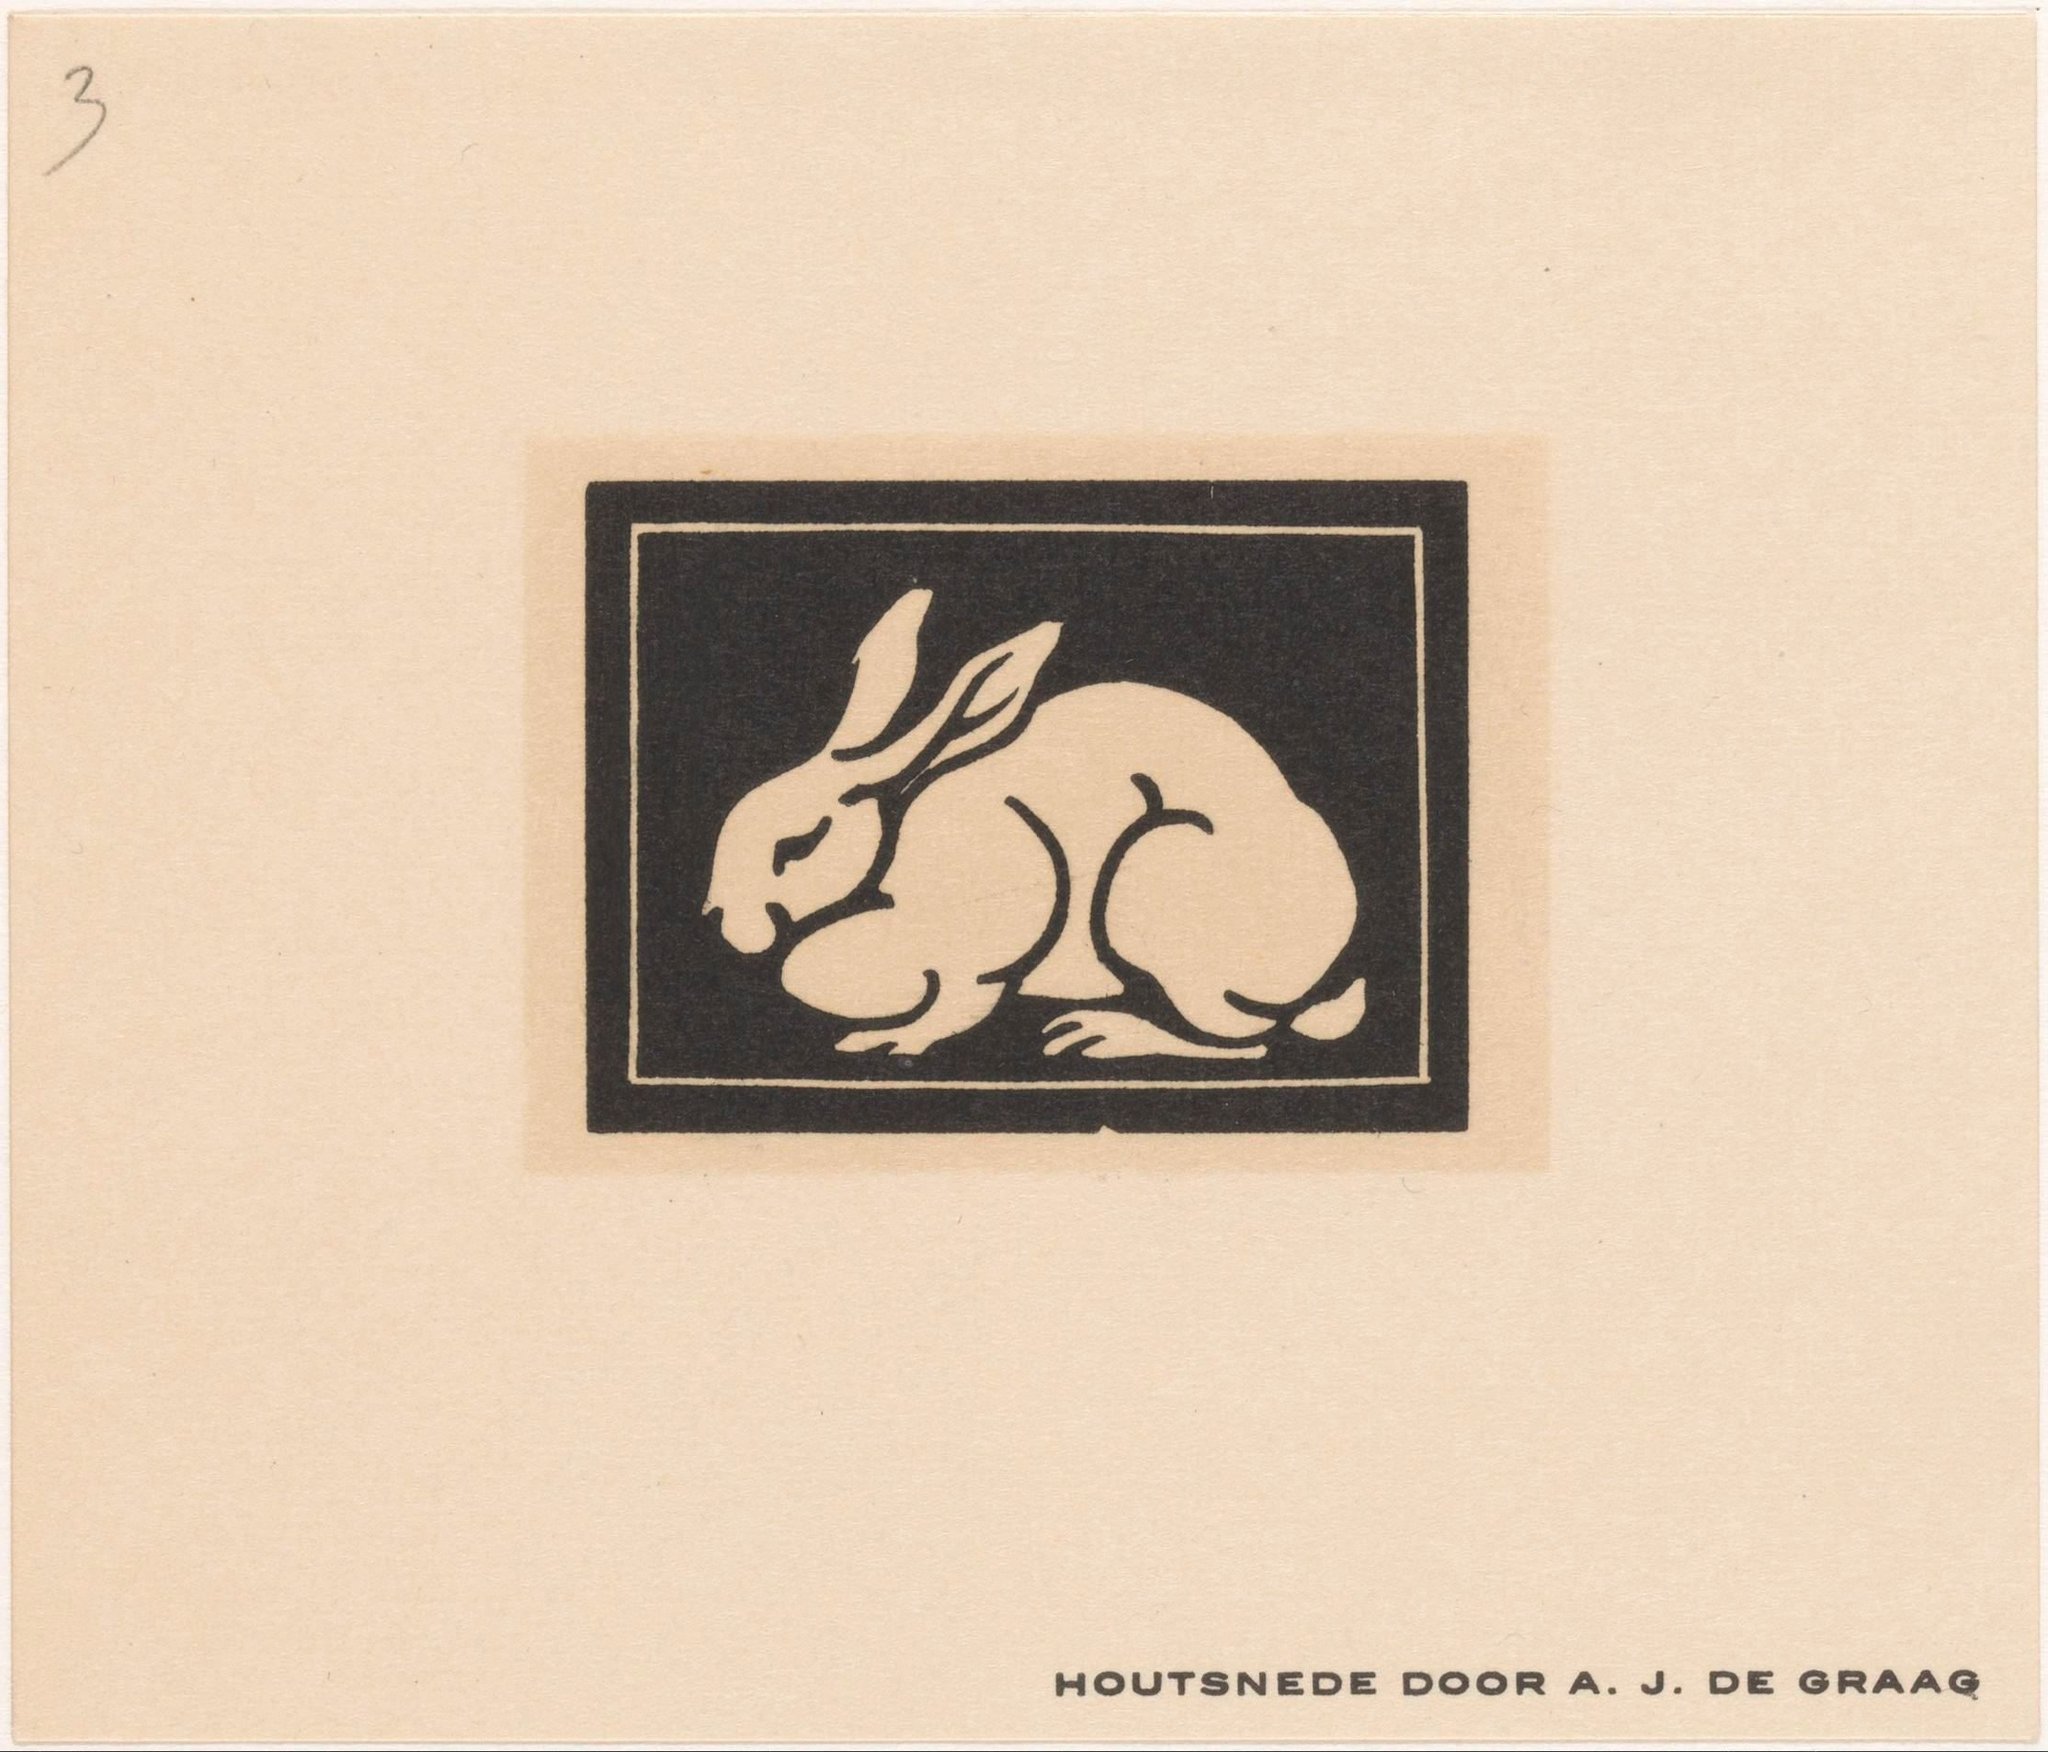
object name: print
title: Konijn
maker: julie de graag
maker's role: draughtsman, print maker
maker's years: 1877-1924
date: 1923-1924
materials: paper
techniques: woodcut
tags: rodents: rabbit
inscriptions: collector's mark: Lugt 2228